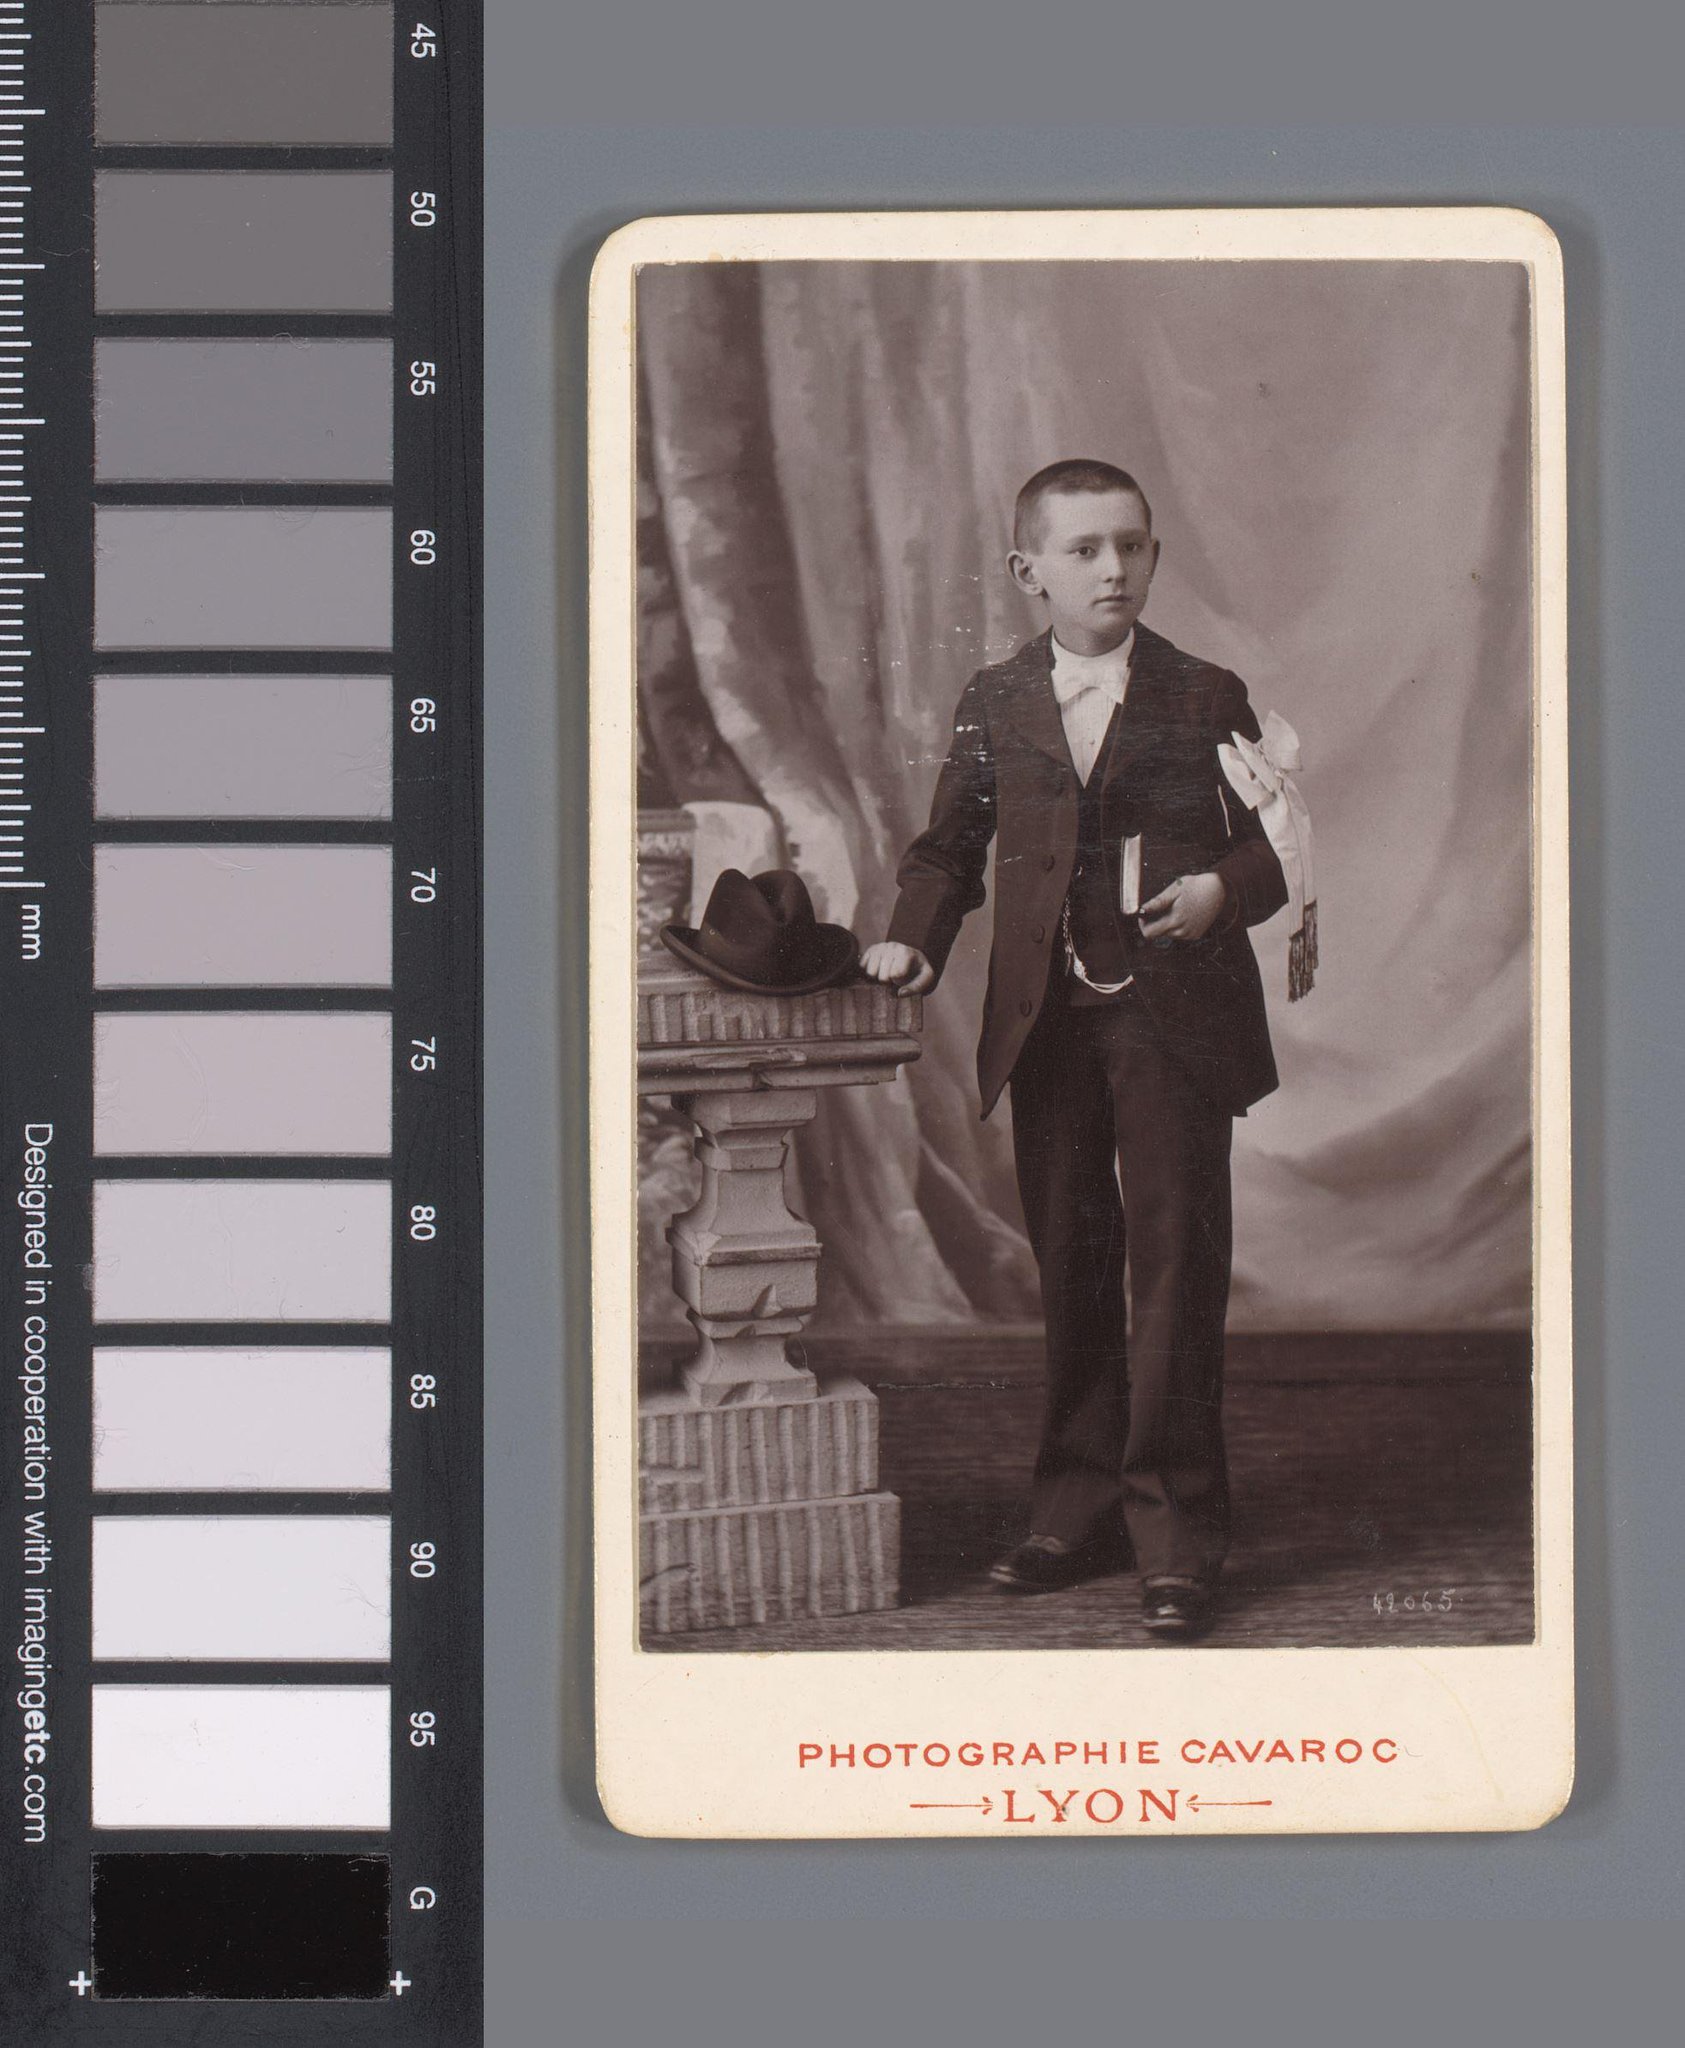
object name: photograph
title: Portret van een onbekende jongen met een strik om arm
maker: honoré cavaroc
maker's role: painter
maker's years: 1846-1931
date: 1900-1914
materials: paper, cardboard, celluloid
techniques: gelatin silver print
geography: lyon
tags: boy (child between toddler and youth), anonymous historical person portrayed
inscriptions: address: ‘RUE VICTOR-HUGO/ 6/ PRÉS BELLECOUR/ LYON’, number: ‘42065’, inscription: ‘Les Clichés sont conservés/ R. DECHAVAN NBS. PARIS’